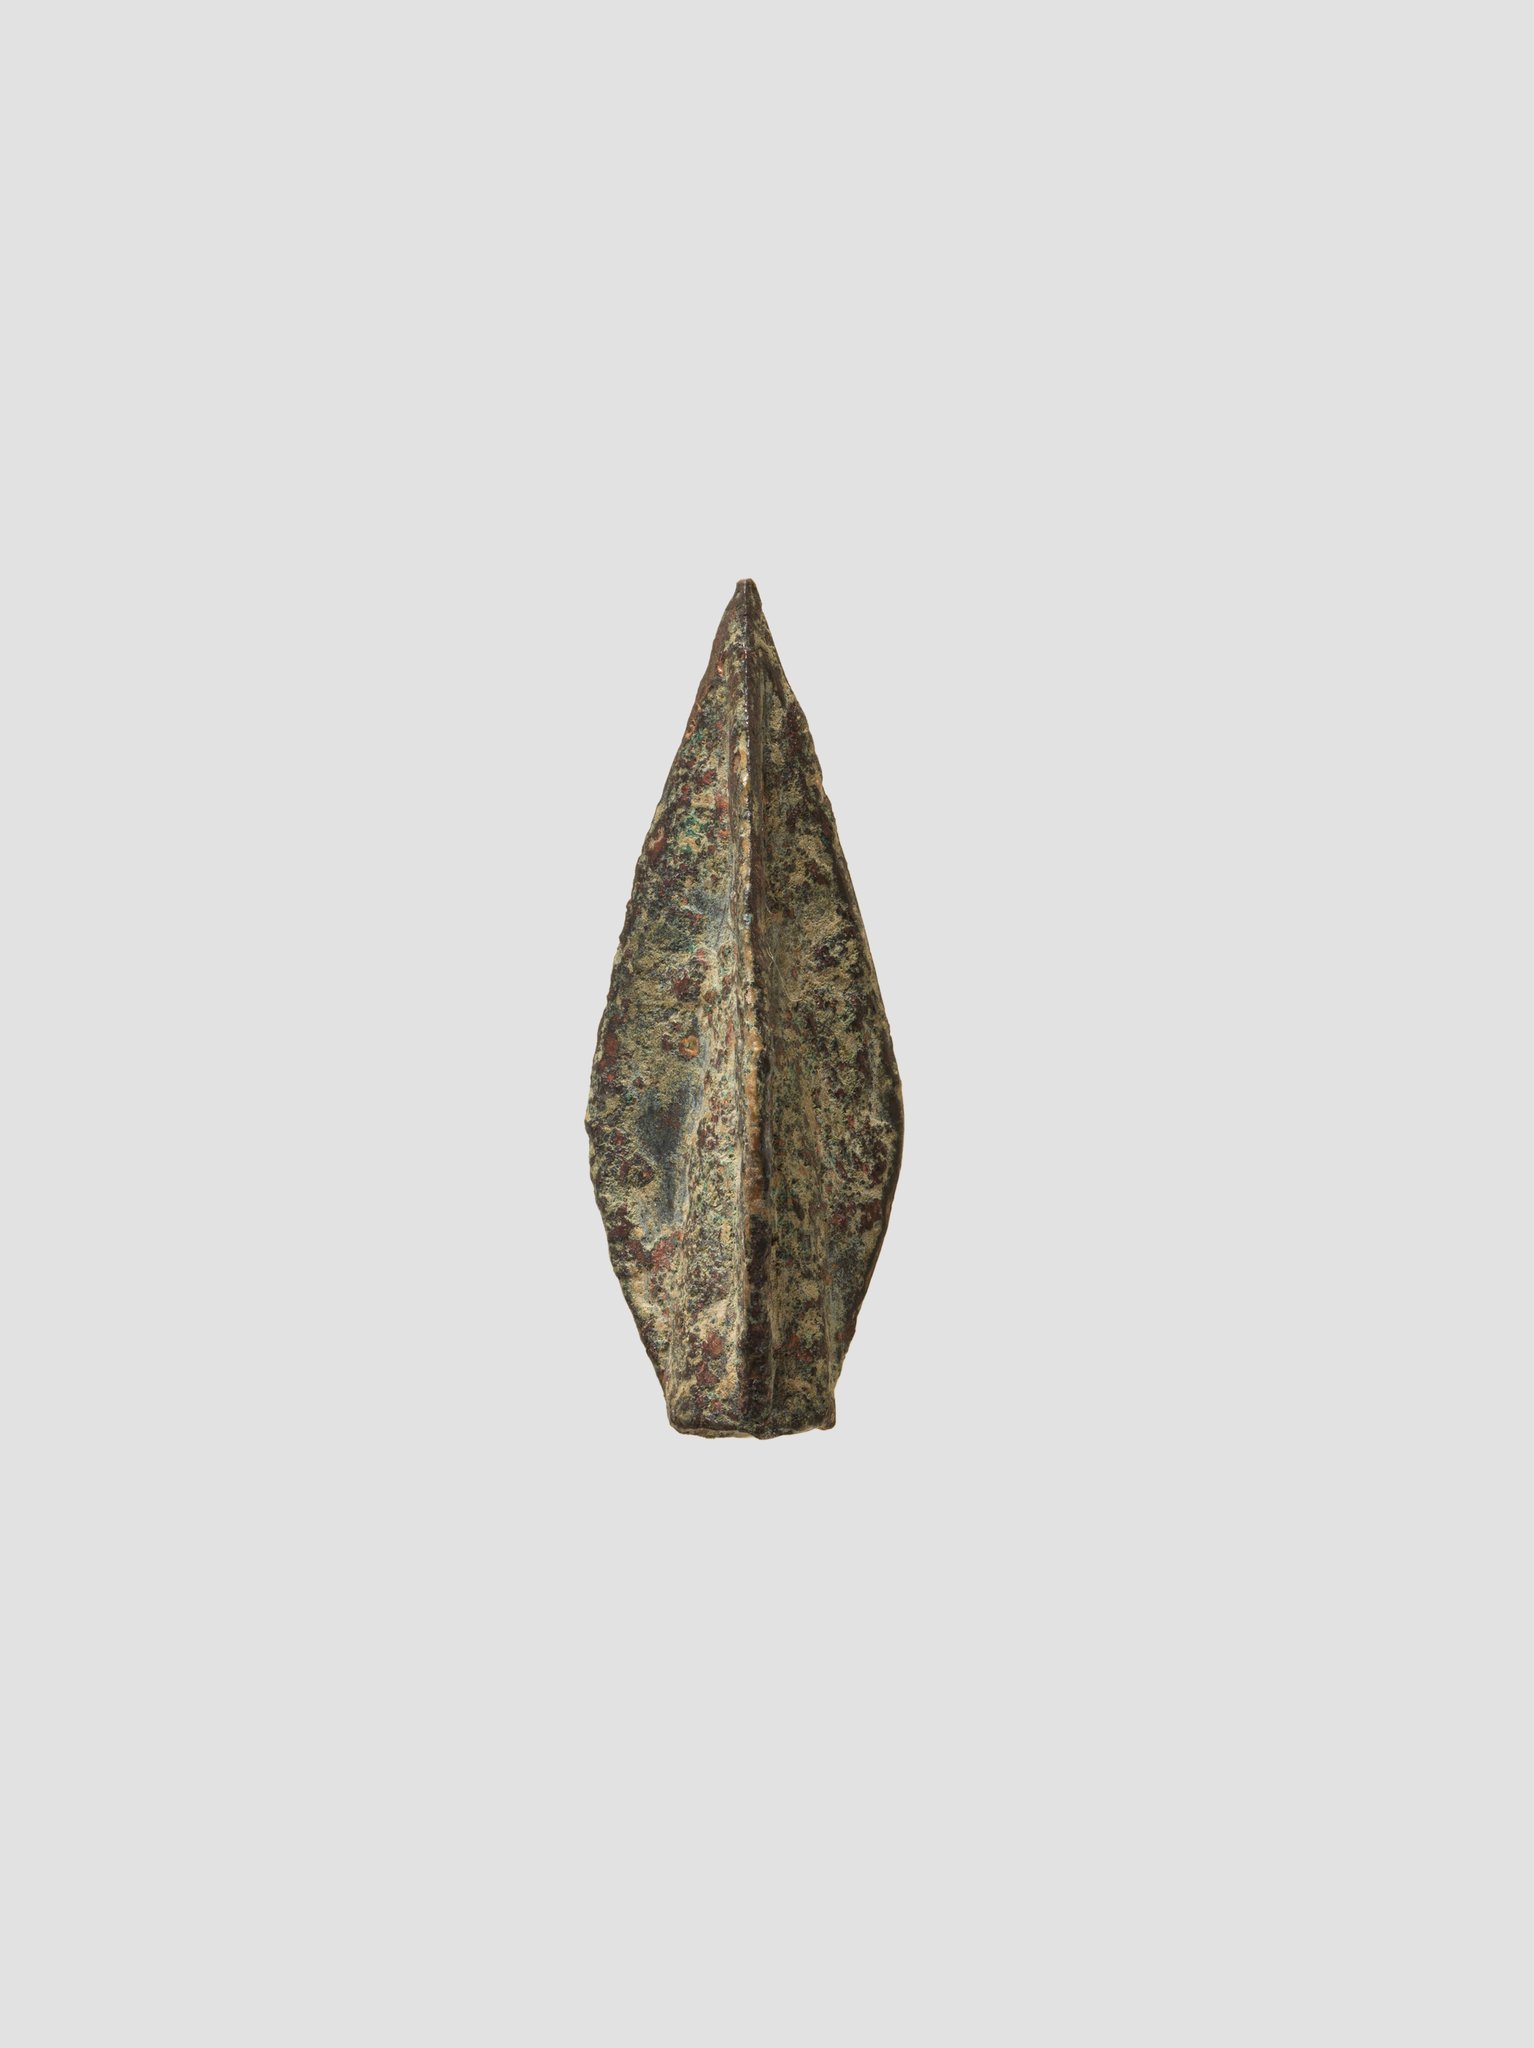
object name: arrowhead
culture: achaemenid or seleucid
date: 400-201 BCE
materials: bronze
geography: iran